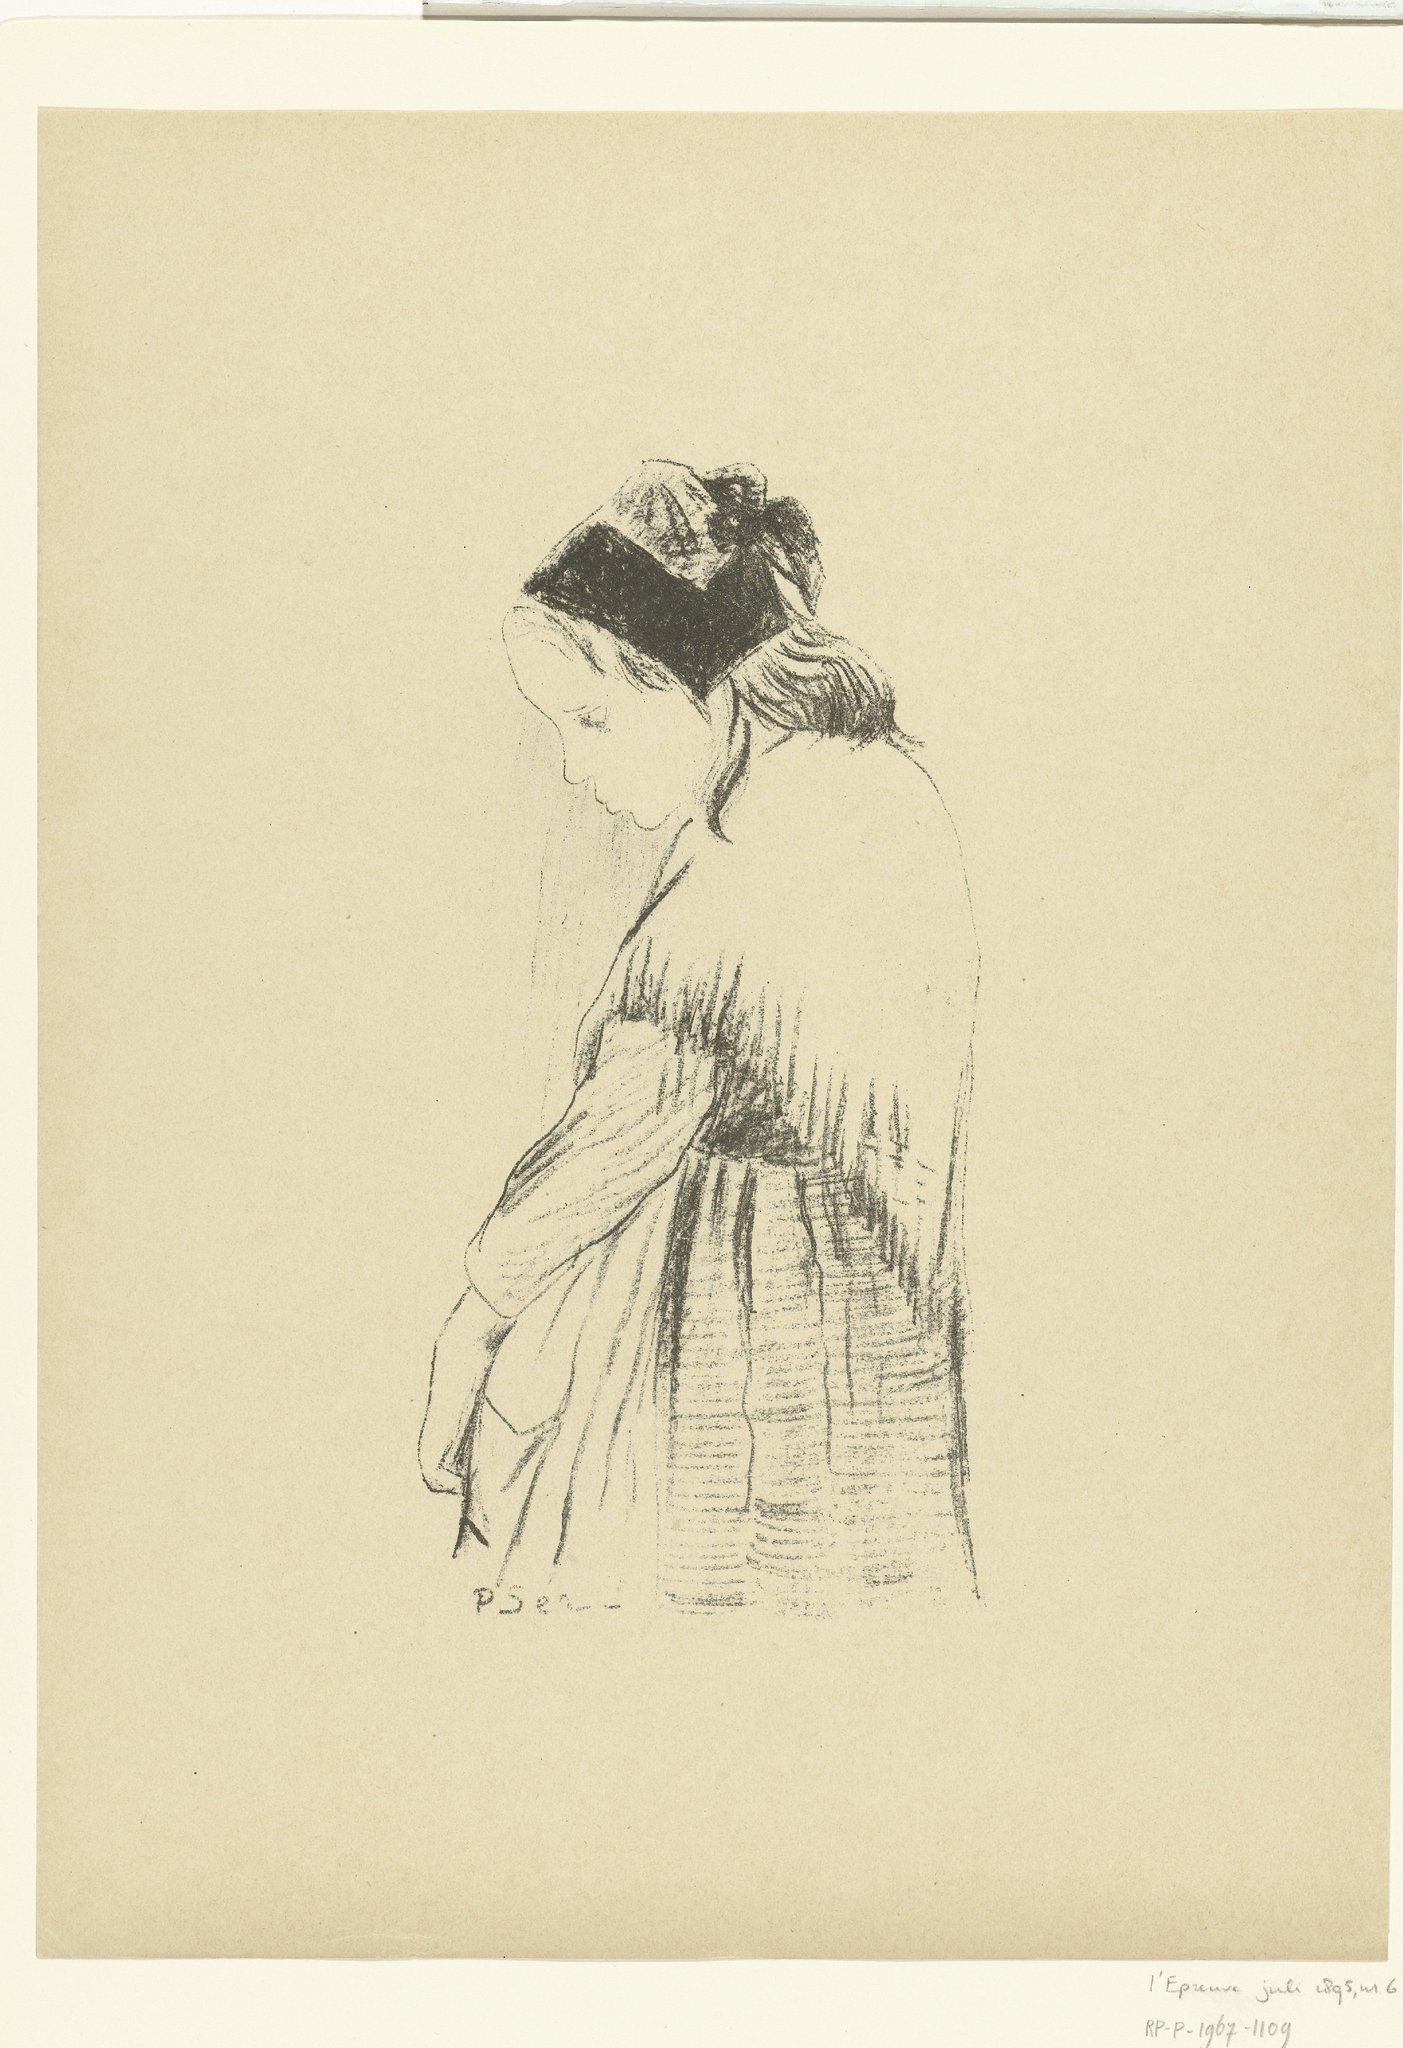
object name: print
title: Meisje uit Bretagne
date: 1807-1895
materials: paper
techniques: lithograph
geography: paris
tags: female infant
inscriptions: collector's mark: Lugt 2760, collector's mark: Lugt 2228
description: Verschenen in album met tien originele prenten als supplement bij tijdschrift: L'Epreuve, juli 1895, prent nr. 6